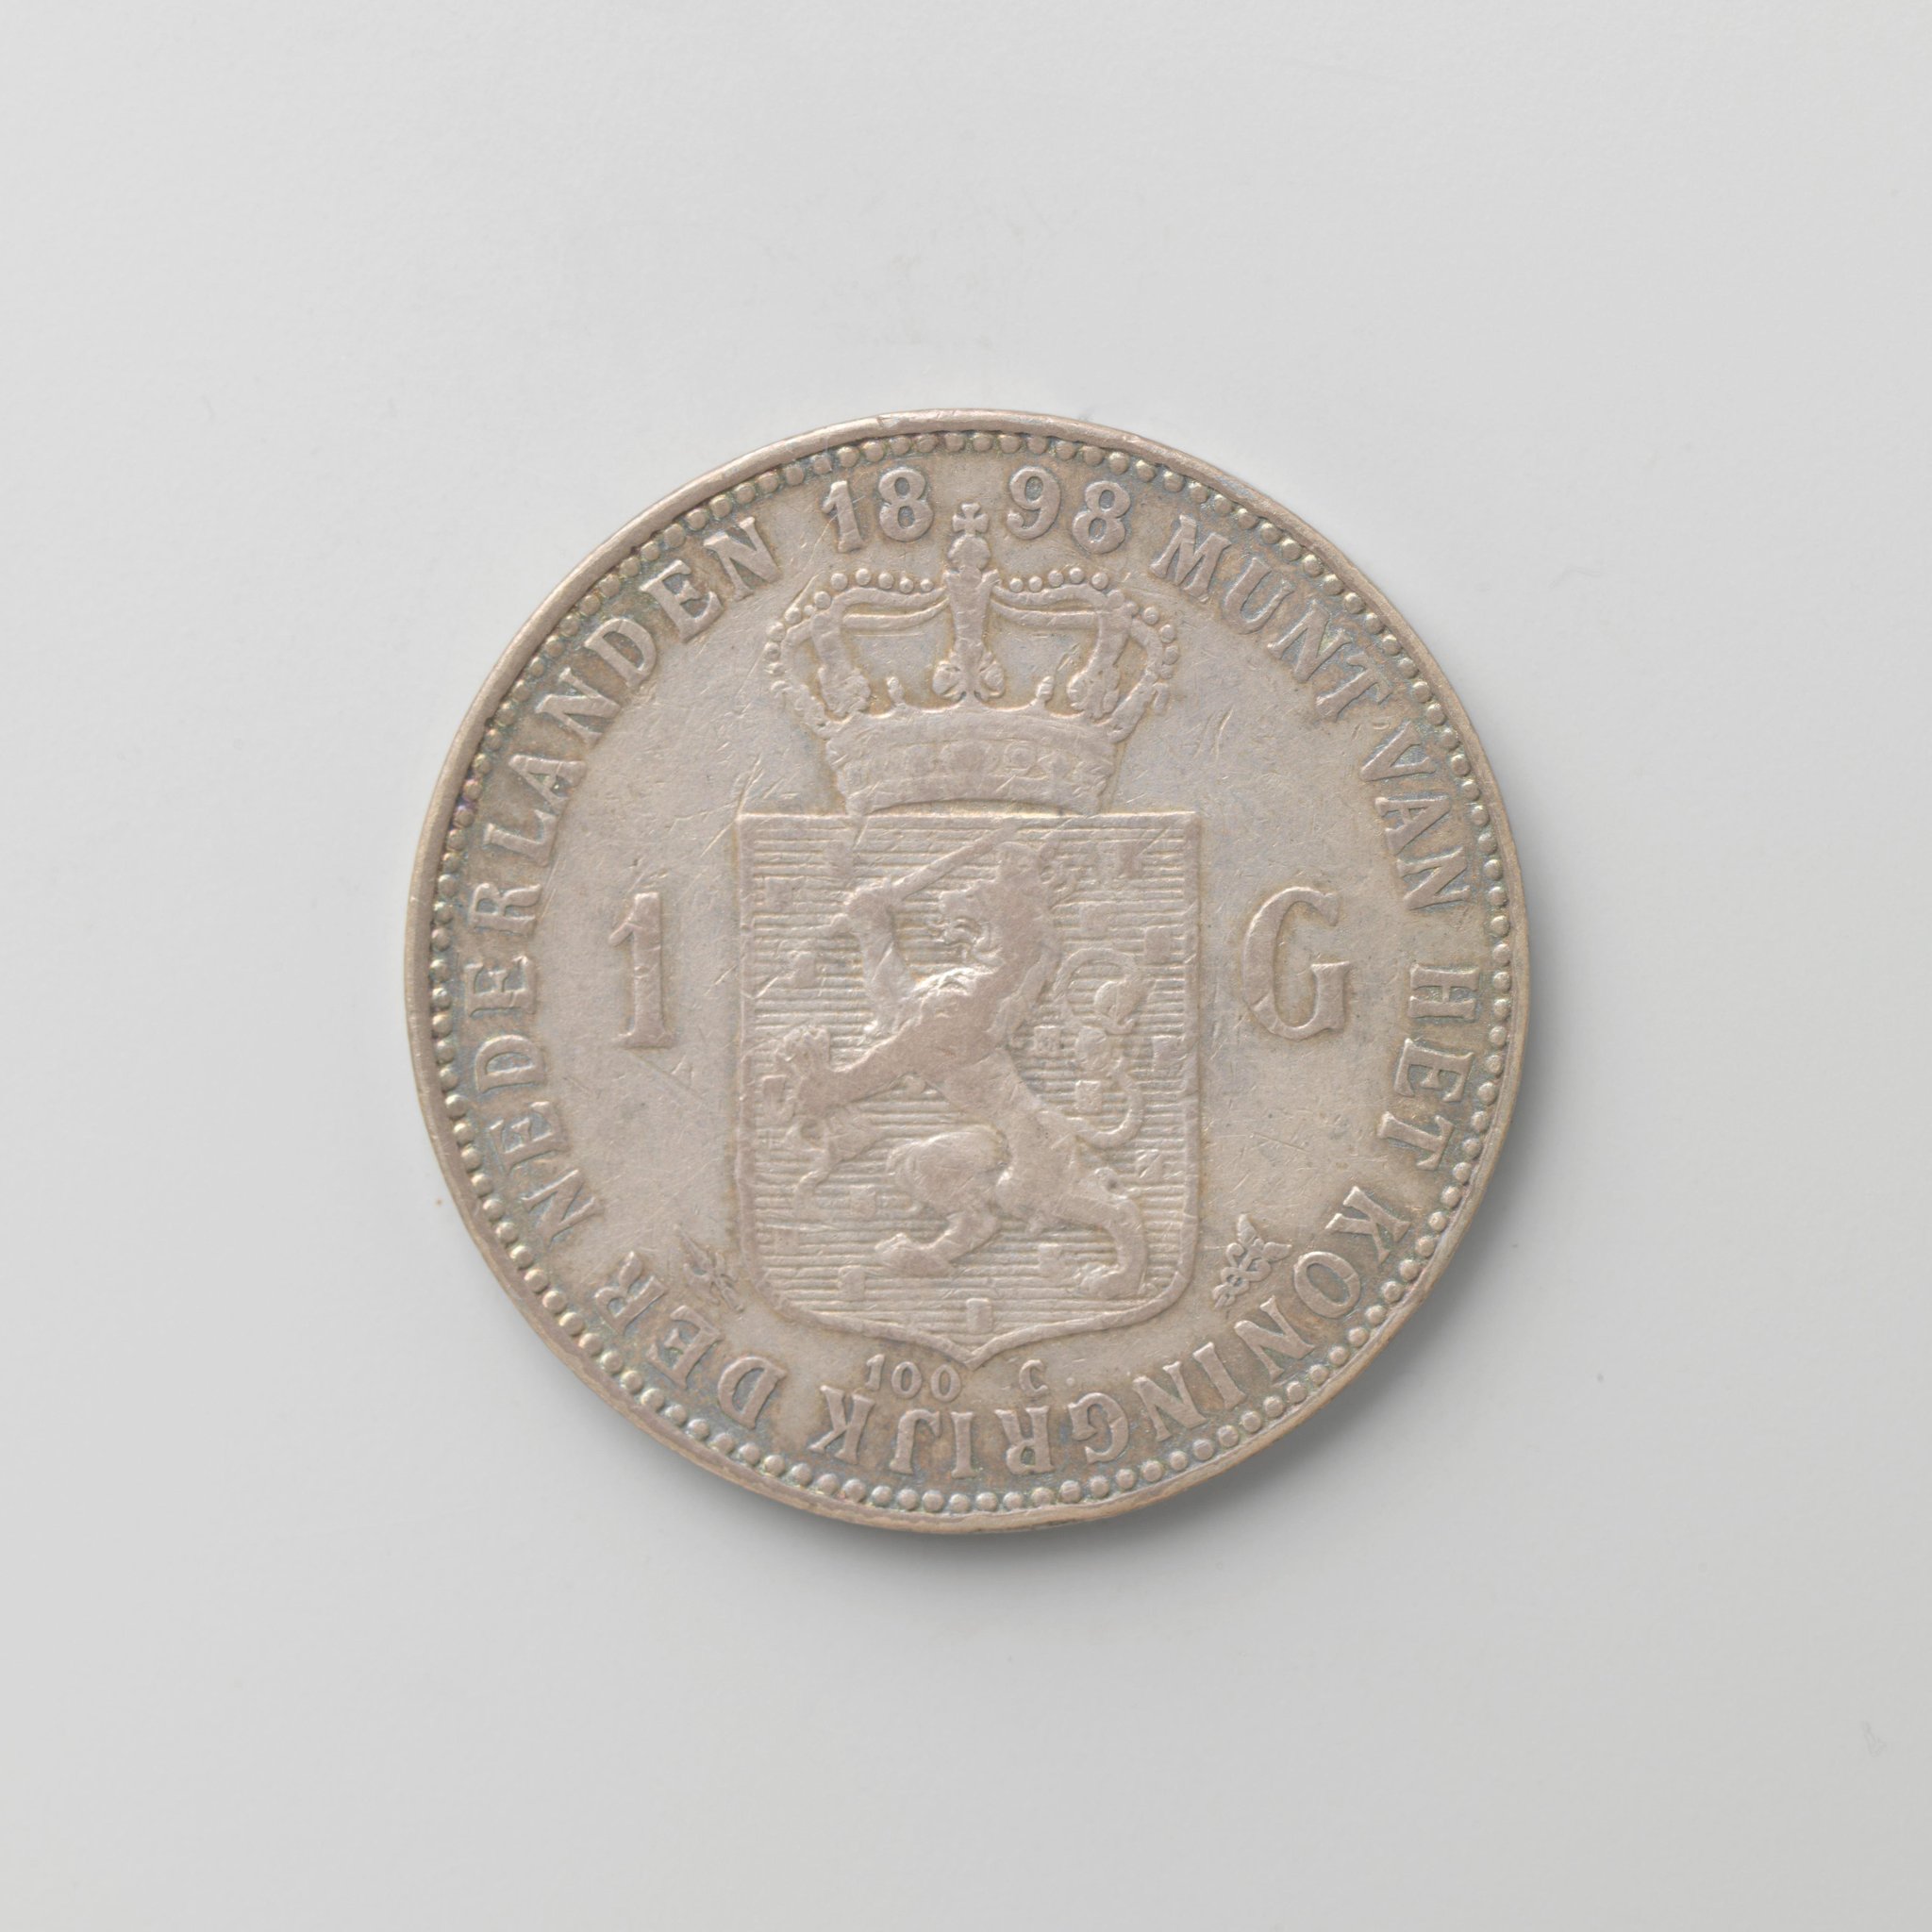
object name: coin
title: Nederlandse gulden,1898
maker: wilhelmina of the netherlands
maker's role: print maker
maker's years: 1880-1962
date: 1898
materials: silver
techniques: striking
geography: utrecht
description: Zilveren munt. Voorzijde: hoofd met diadeem naar links. Keerzijde: tussen waarde-aanduiding 1 G gekroond rijkswapenschild. Jaartal bovenaan in omschrift. Randschrift.